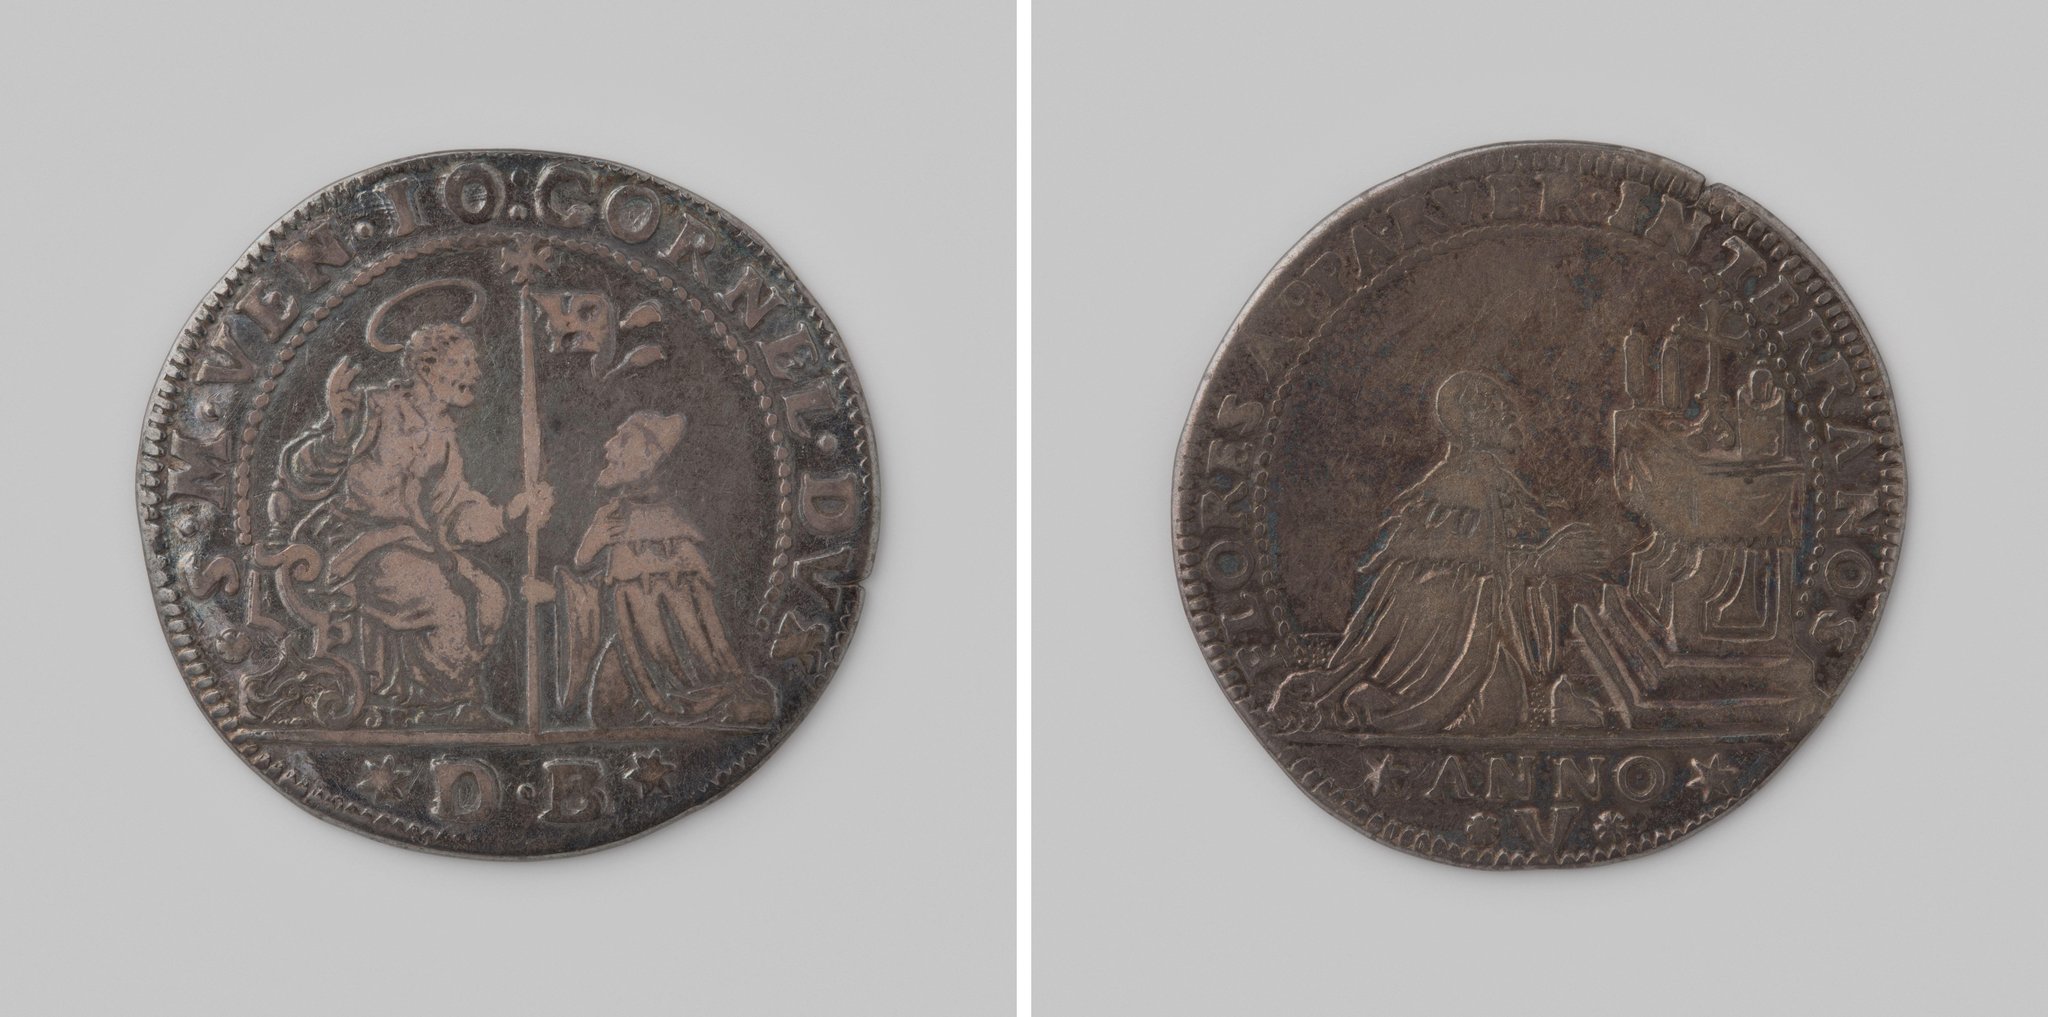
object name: coin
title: Osella uit de republiek Venetië van doge Giovanni Cornaro, 1629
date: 1629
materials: silver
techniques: striking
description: Zilveren munt. Voorzijde: links de heilige Marcus, gezeten en rechts de doge, knielend met tussen hen een lans, waarop kruis, die beiden vasthouden. In de afsnede de letters D en B [=muntmeester Domenego Basadonna]. Keerzijde: man, blootshoofds die voor het altaar knielt. In de afsnede in twee regels: Anno V [=1629].